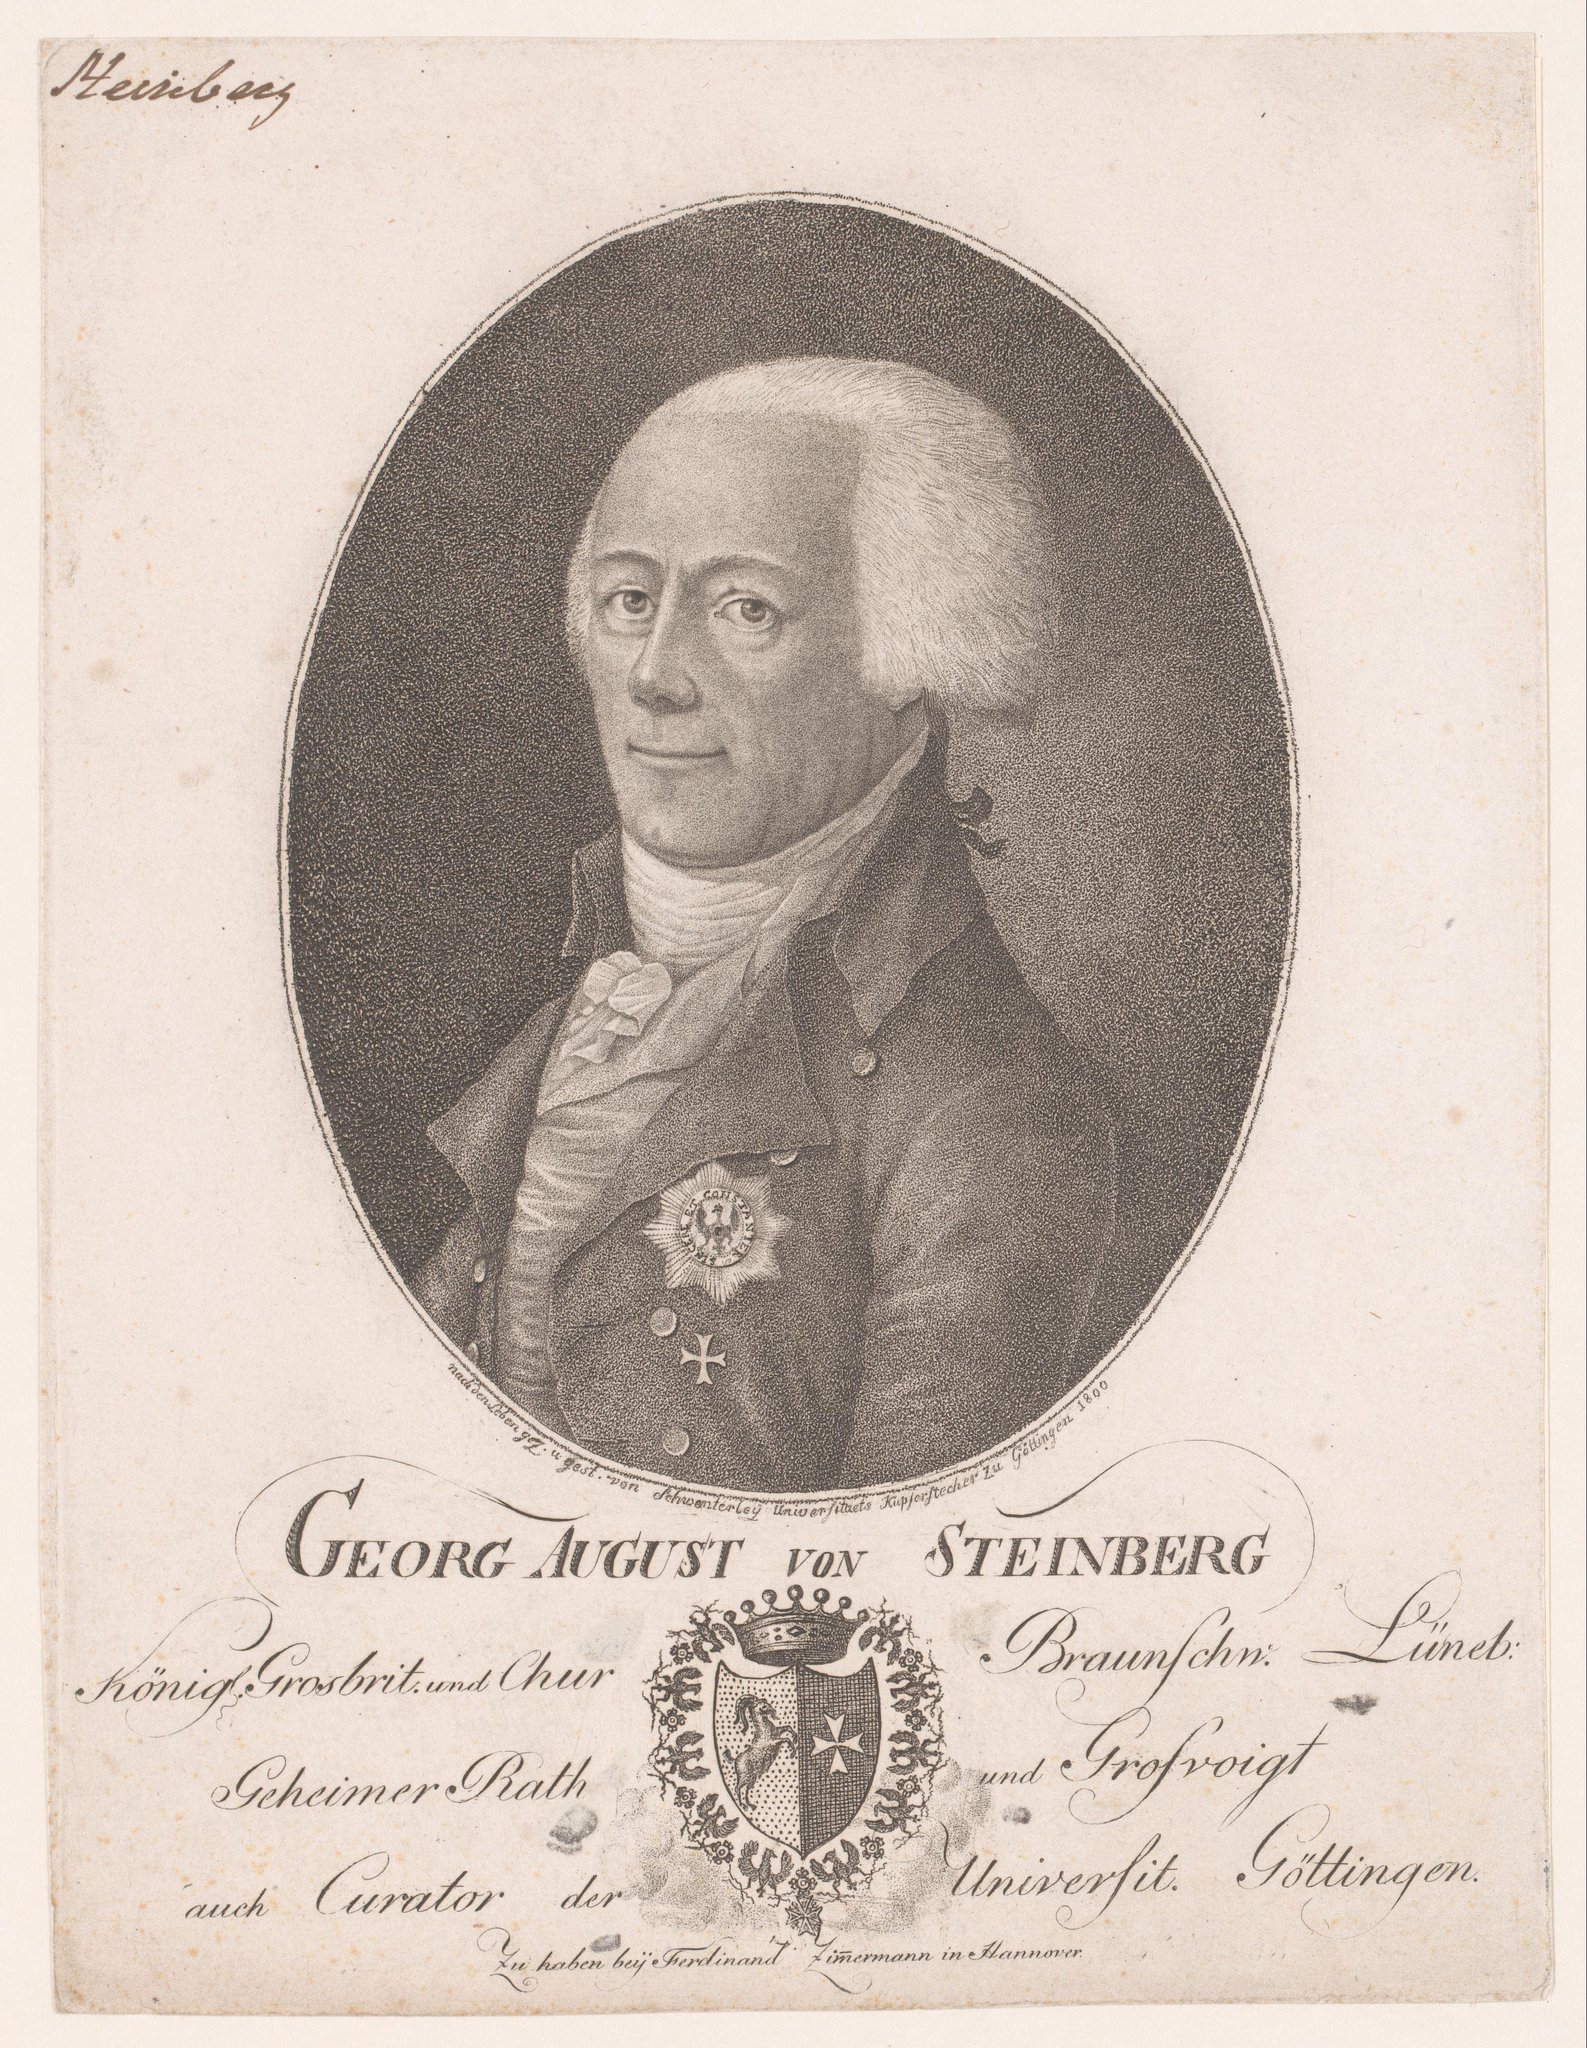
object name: print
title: Portret van Georg August von Steinberg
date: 1800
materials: paper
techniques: stippling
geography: hannover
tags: historical persons, armorial bearing, heraldry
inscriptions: collector's mark: Lugt 2228